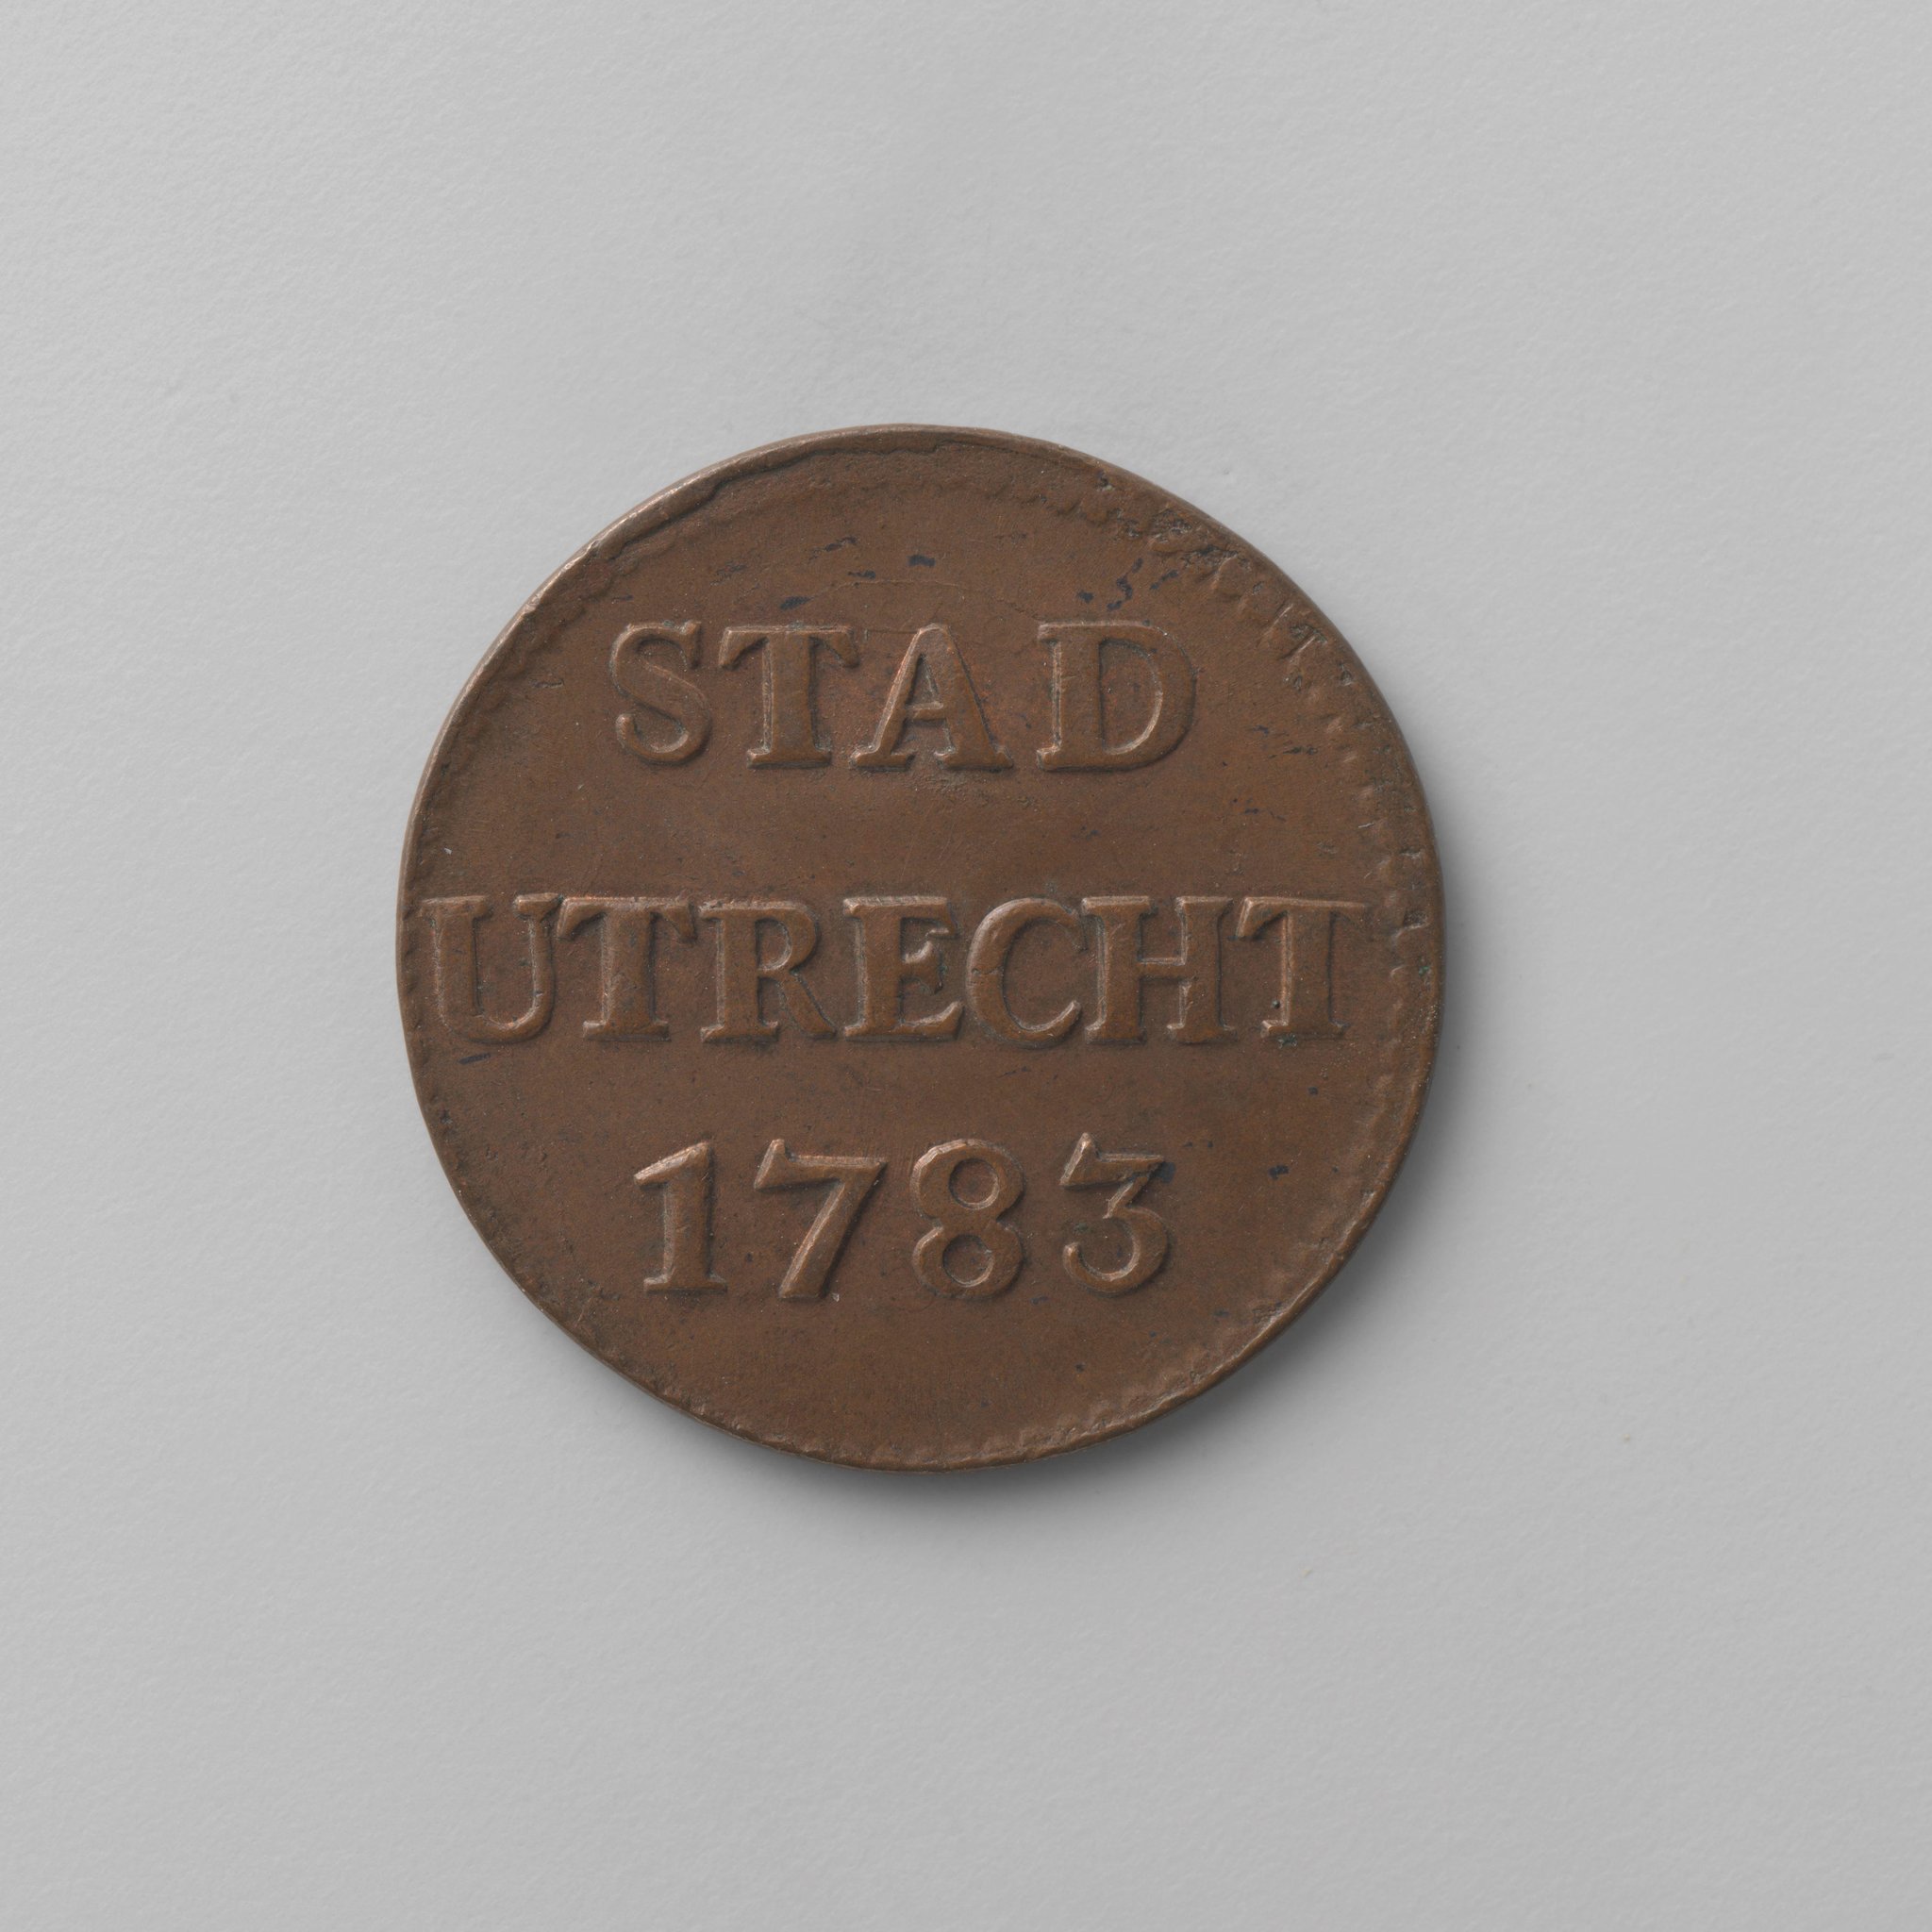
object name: coin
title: Duit van de stad Utrecht, 1783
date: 1783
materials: copper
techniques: striking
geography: utrecht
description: Koperen munt. Voorzijde: gekroond stedelijk wapenschild, gehouden door twee leeuwen met in afsnede dubbele lijn, waaronder een versierde accolade met een grote schelp. Keerzijde: opschrift in twee regels, waaronder jaartal. Jaartal met Arabische 1.